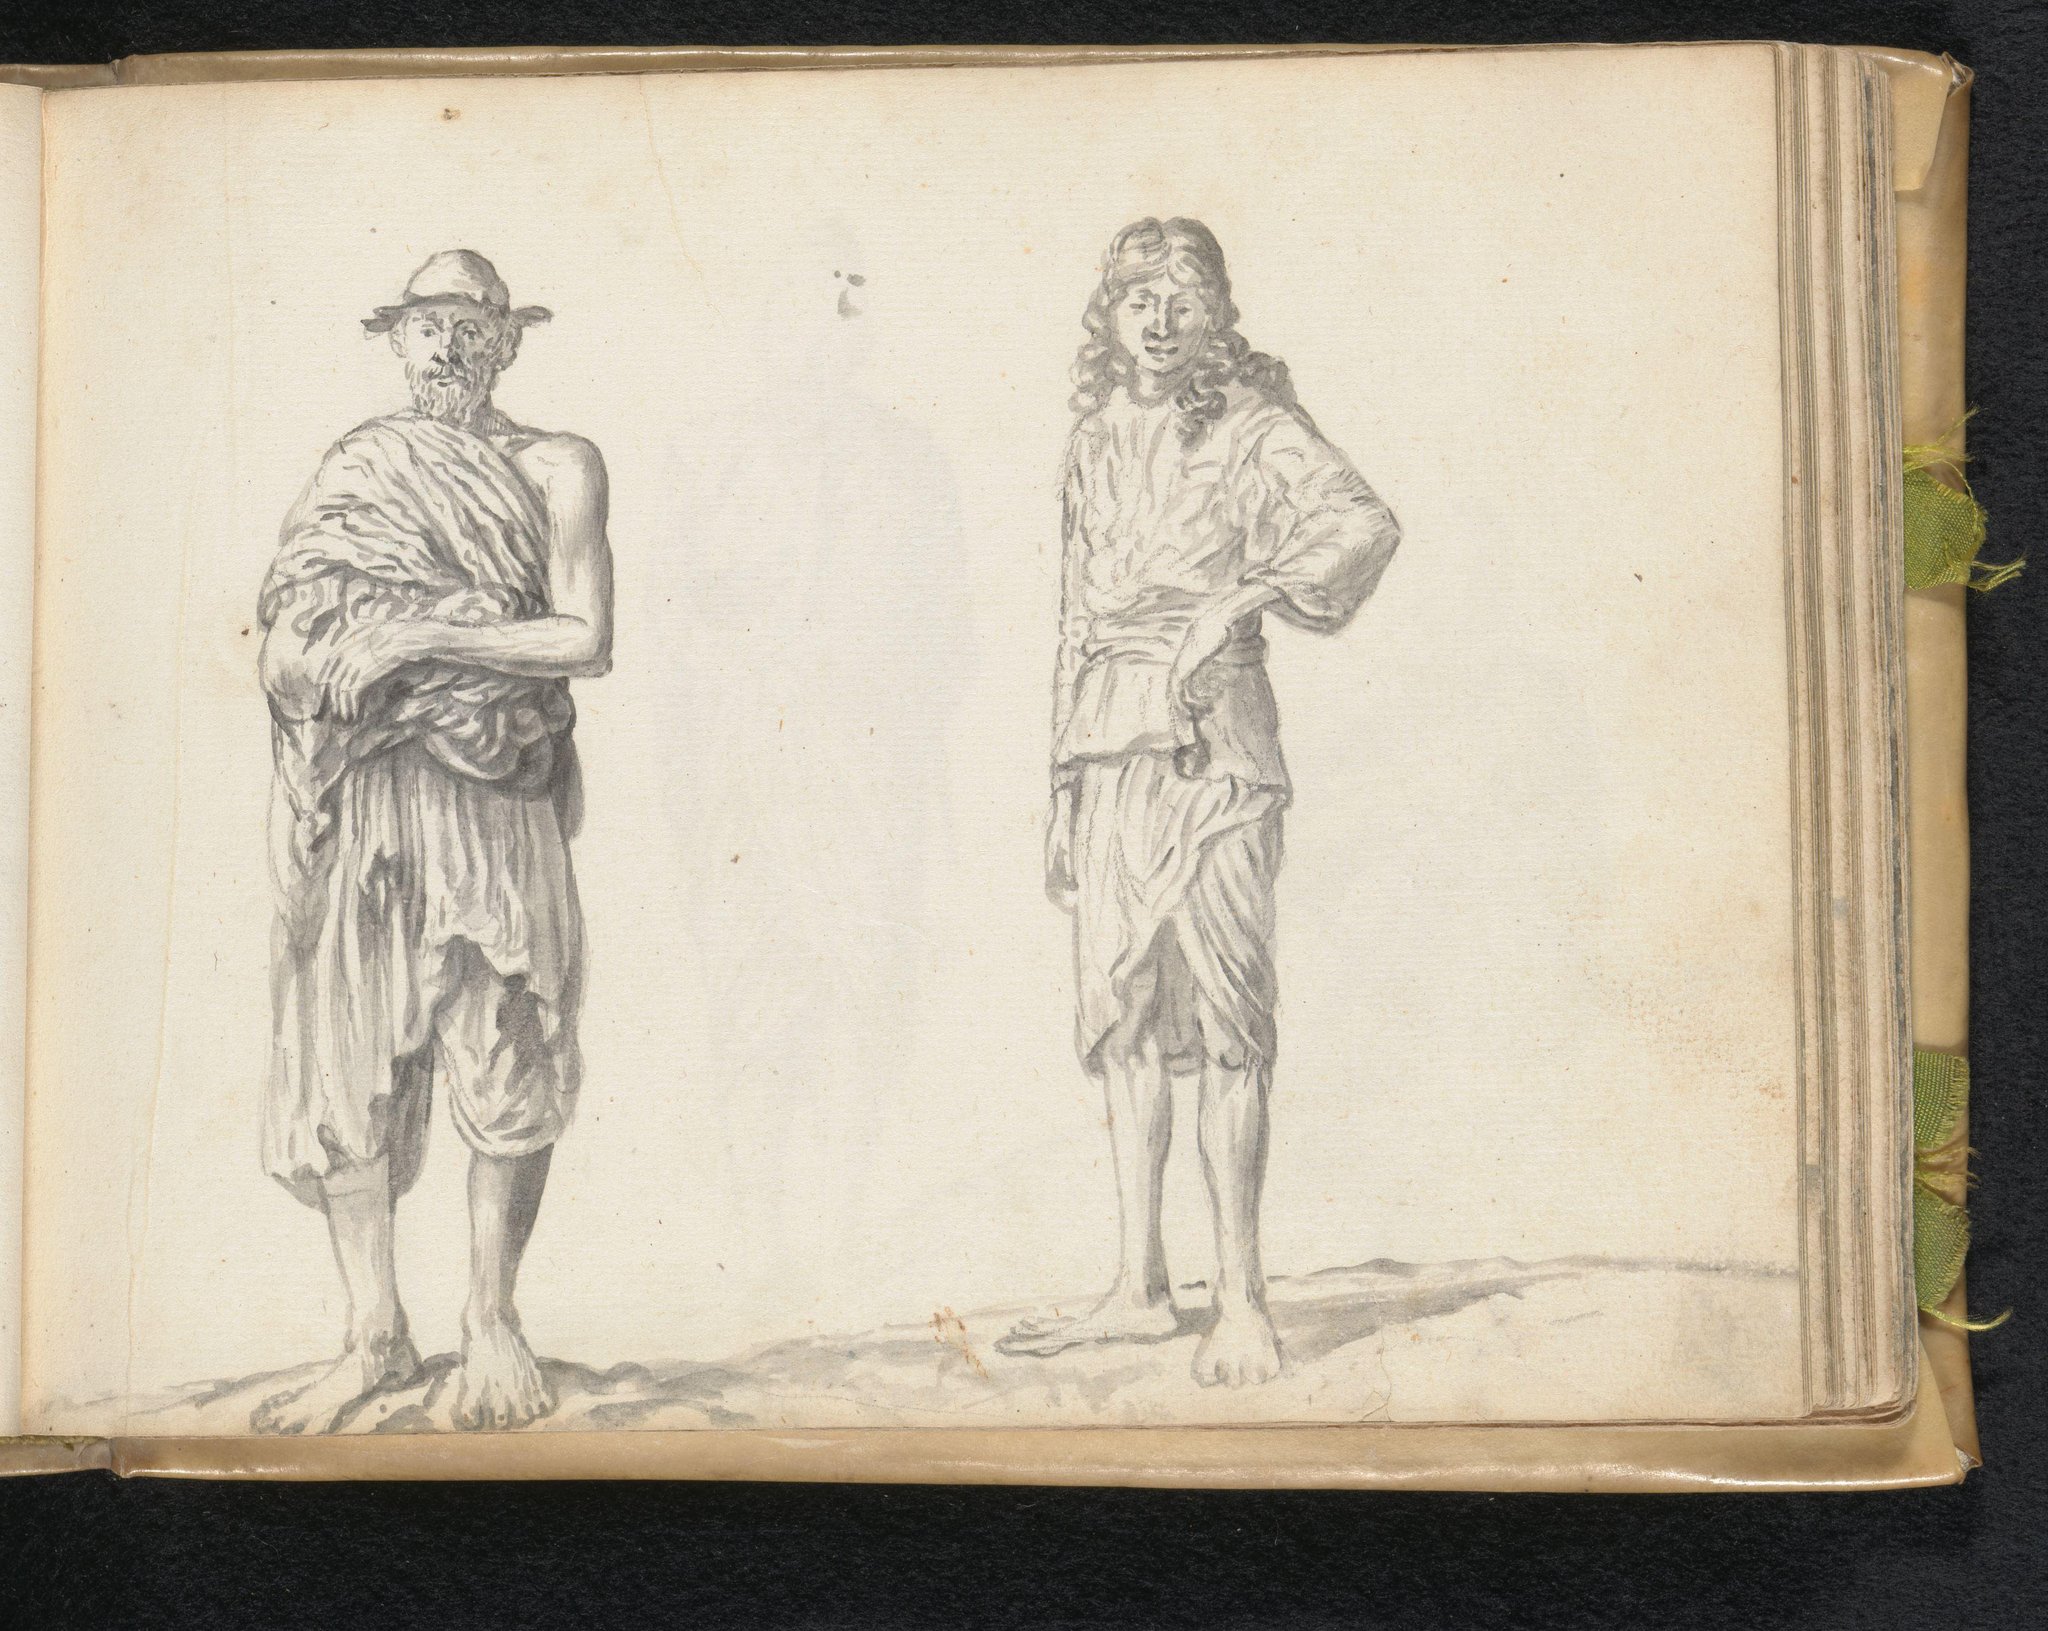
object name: sketchbook leaf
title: Two men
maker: esaias boursse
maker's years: 1631-1672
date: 1662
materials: ink, paper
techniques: brush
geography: sri lanka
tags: asiatic races and peoples (with name), 41d232(...) skirt (lungi), head-gear (with name), clothing for the upper part of the body (with name), asiatic races and peoples: indians, sri lanka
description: Buiten staan twee mannen. De man links draagt een knielang heupkleed (veshti, lungi) en een grote omslagdoek (chadar) om bovenlijf en rechterschouder. Wat hij op het hoofd draagt is niet duidelijk. Het kan een geknoopte doek zijn waarvan de randen en strikken uitsteken. Rechts staat een jonge man die gekleed gaat in een op de Singalese manier schuin gedrapeerd heupkleed. Daarboven een hooggesloten hemd met lange mouwen (kamisaya). Onduidelijk is of het hemd tot over de heupen hangt met een doek om de taille, of dat het hemd kort is en het heupkleed breed is omgeslagen in de taille. Zijn lange haar is in het midden gescheiden en hangt golvend over zijn schouders. De herkomst van de linkerman is waarschijnlijk Zuid-India of Jaffna; de rechterman is Singalees uit voormalig Portugees Colombo. Beiden zijn waarschijnlijk tewerkgesteld in de wederopbouw. Blad 66 uit een schetsboek met 117 bladen.